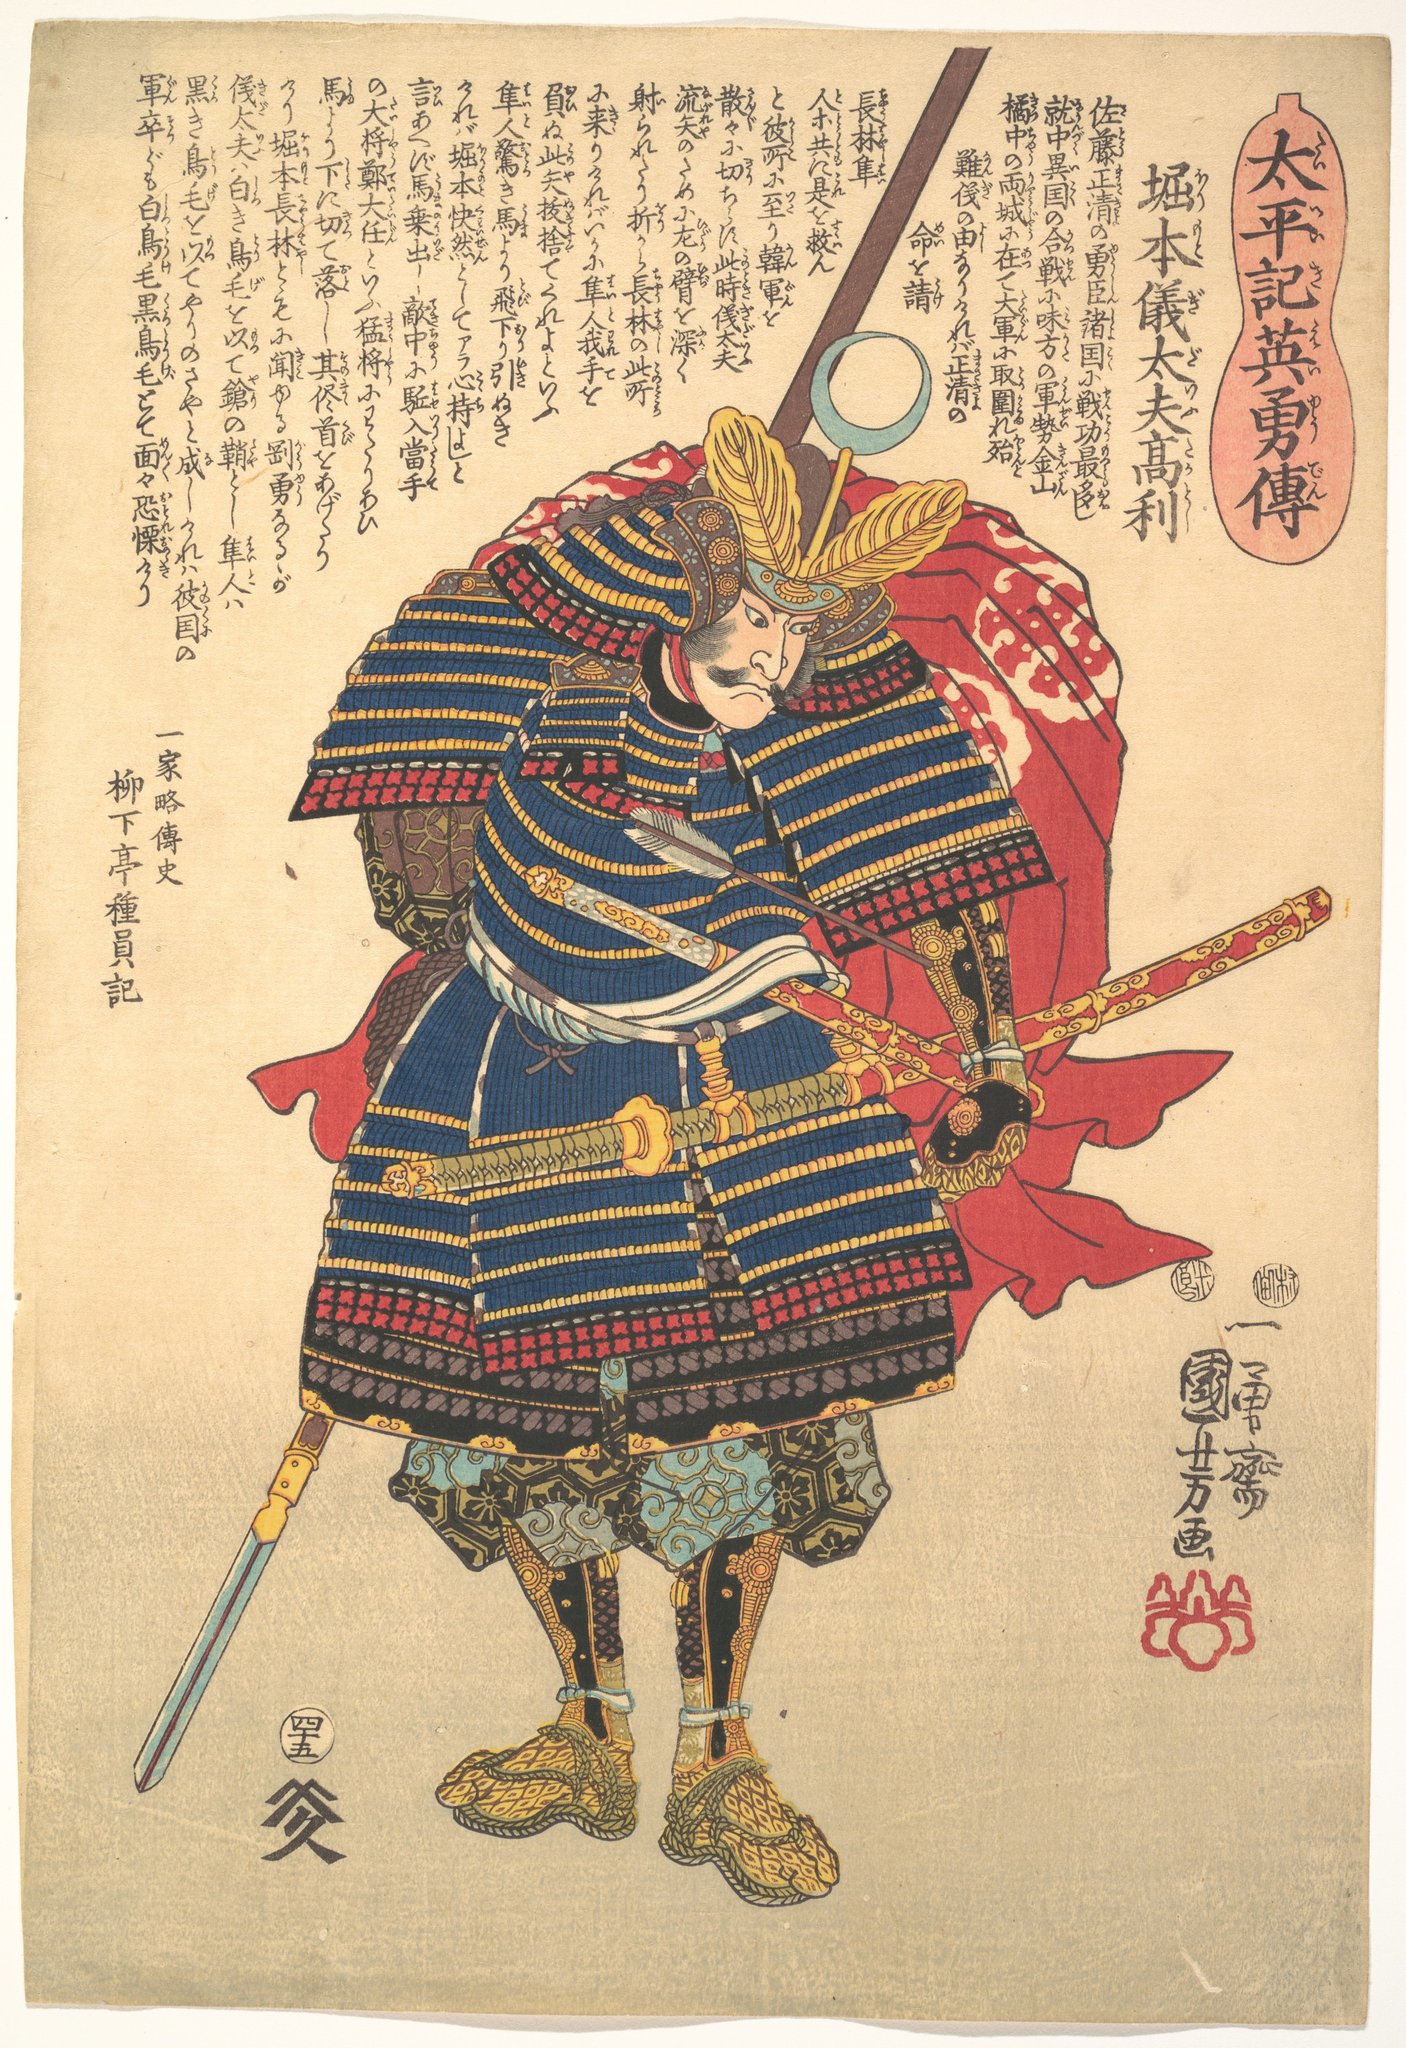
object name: print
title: Horimoto Gidayū Takatoshi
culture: japanese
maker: utagawa kuniyoshi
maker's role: artist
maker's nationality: japanese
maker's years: 1797-1861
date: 1848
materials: ink, paper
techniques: woodblock print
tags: swords,men